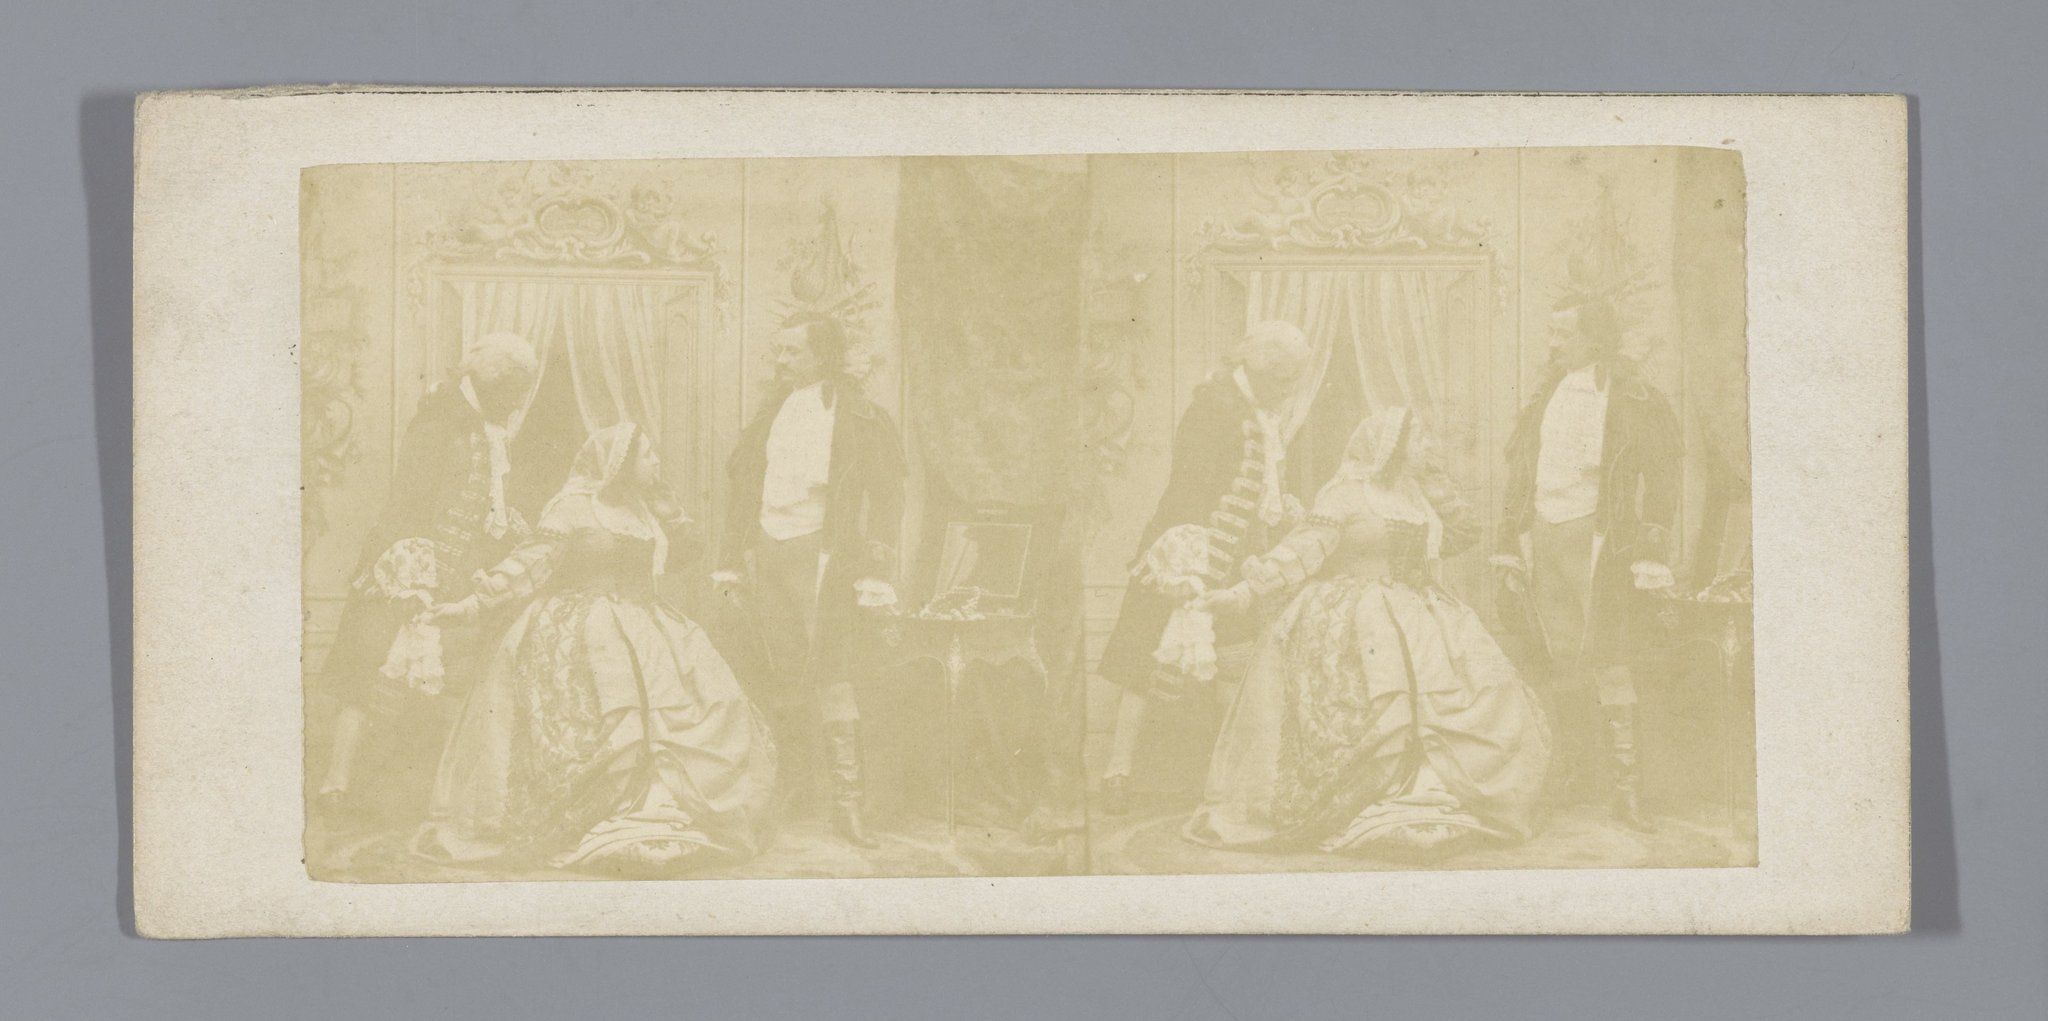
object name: stereograph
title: Vrouw en twee mannen in historische kostuums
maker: Anonymous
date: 1850-1880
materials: cardboard, photographic support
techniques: albumen print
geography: europe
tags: historical costume, europe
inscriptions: number: ‘No. 43.’